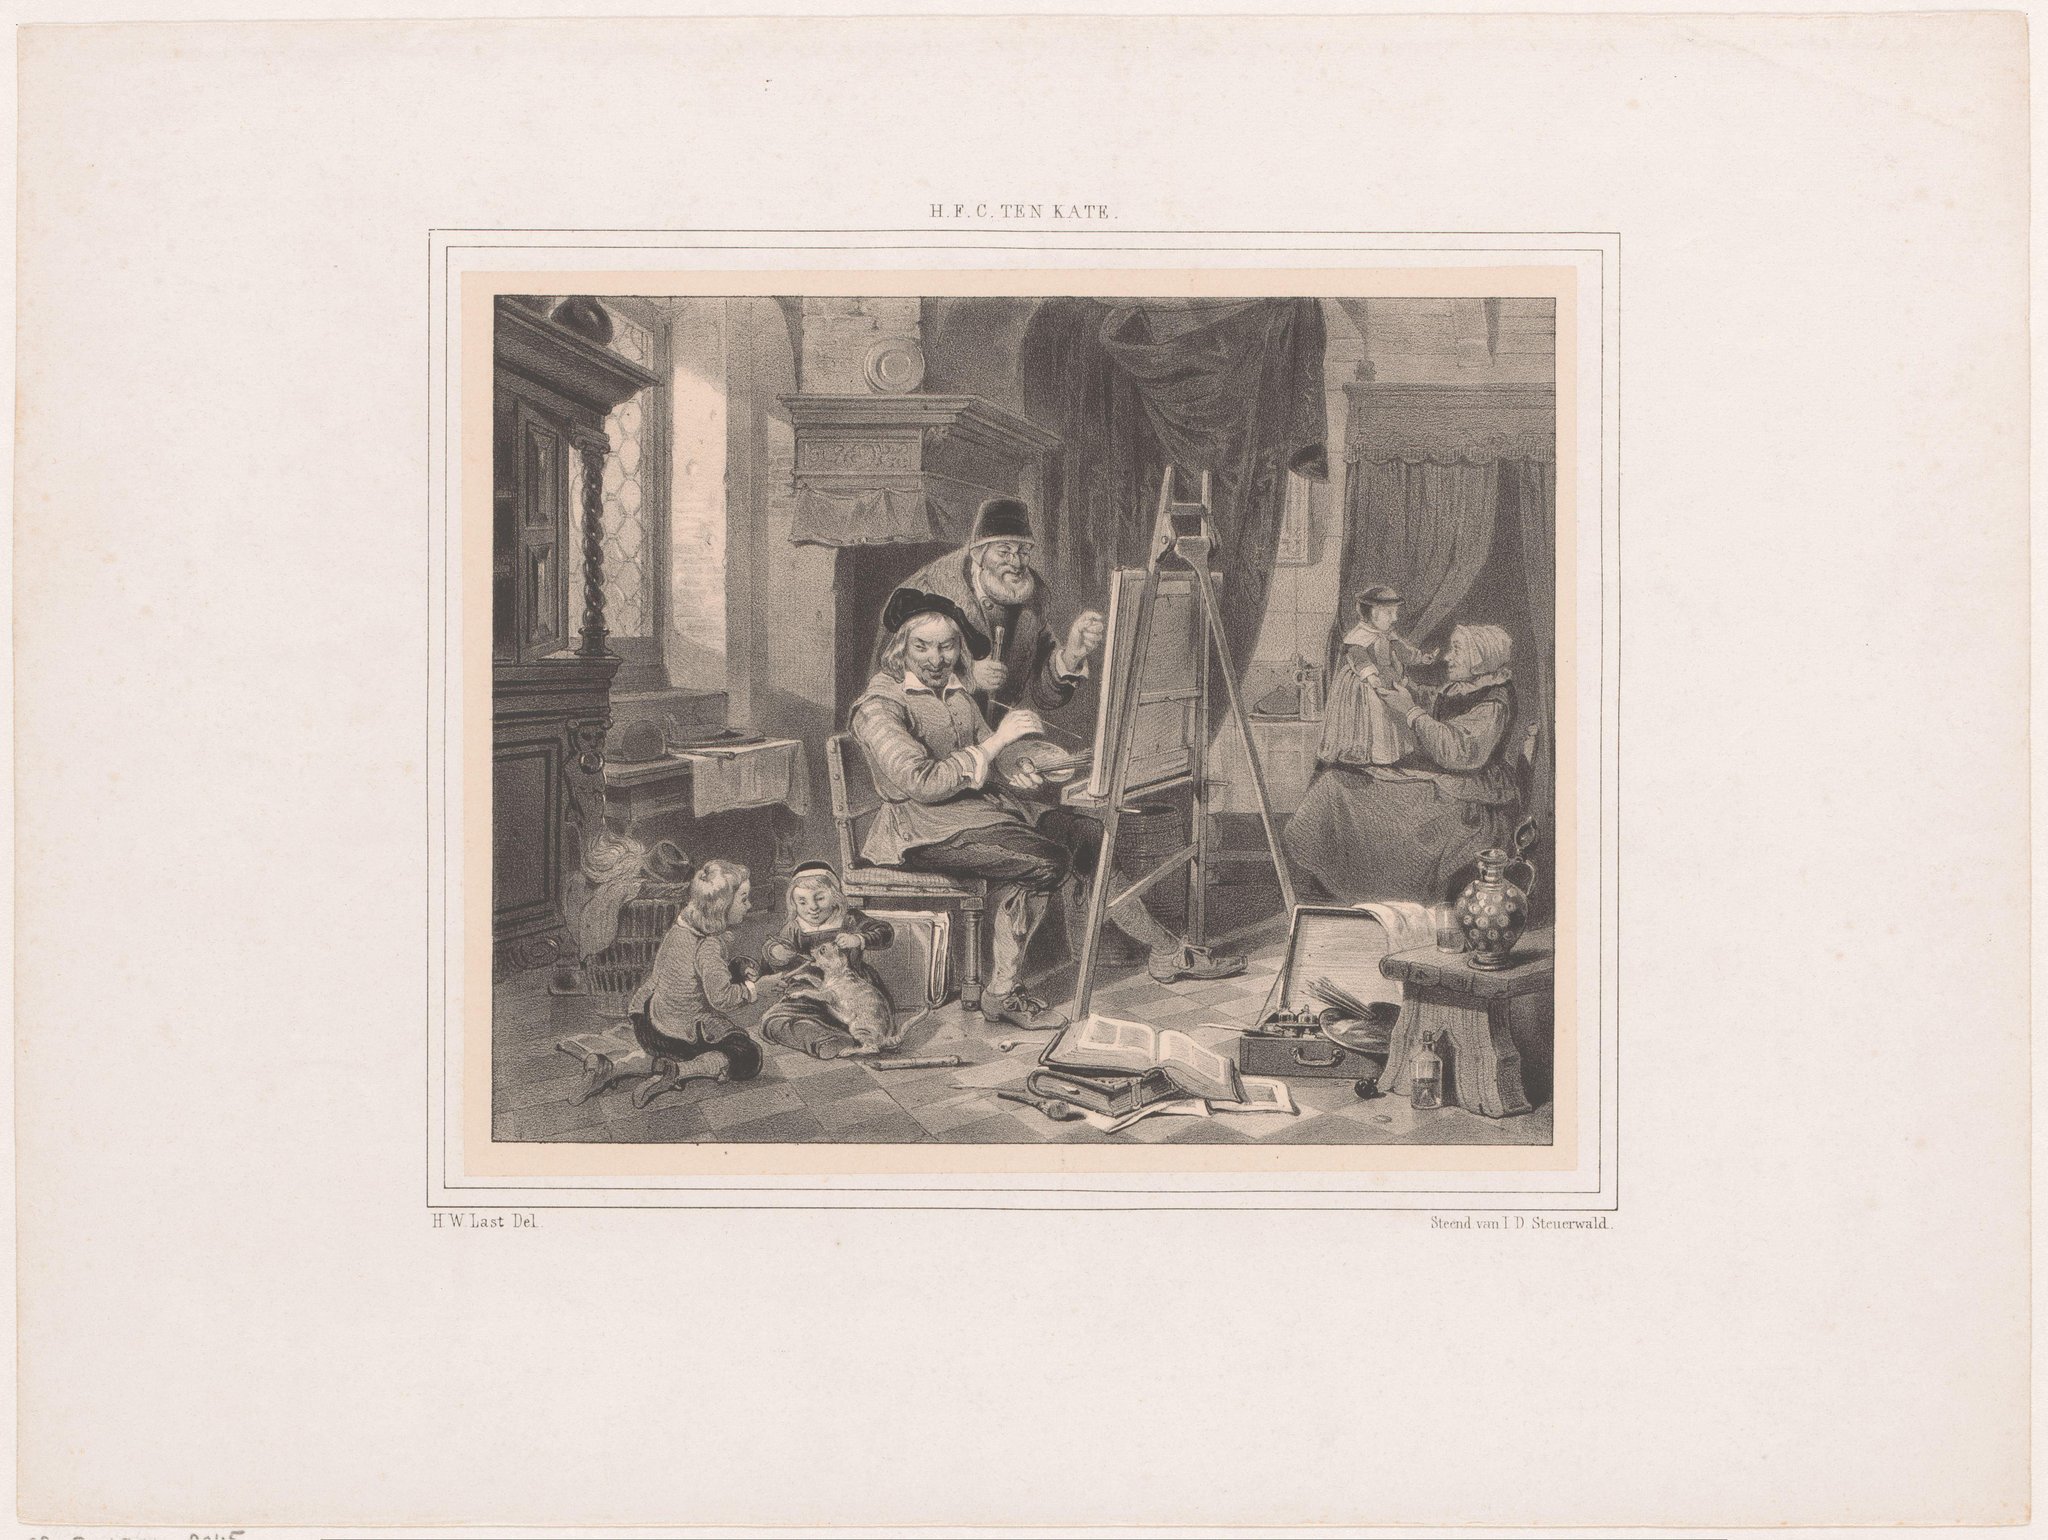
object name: print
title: Schilder in zijn atelier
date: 1827-1863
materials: paper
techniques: lithograph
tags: children's games and plays, cat, easel, working situations ~ painter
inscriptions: collector's mark: Lugt 2228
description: Een oude man kijkt over de schouder van de schilder naar het doek op de ezel. De schilder kijkt naar twee kinderen die een kat met een lepel te eten geven. In de achtergrond een vrouw met een kind op schoot.